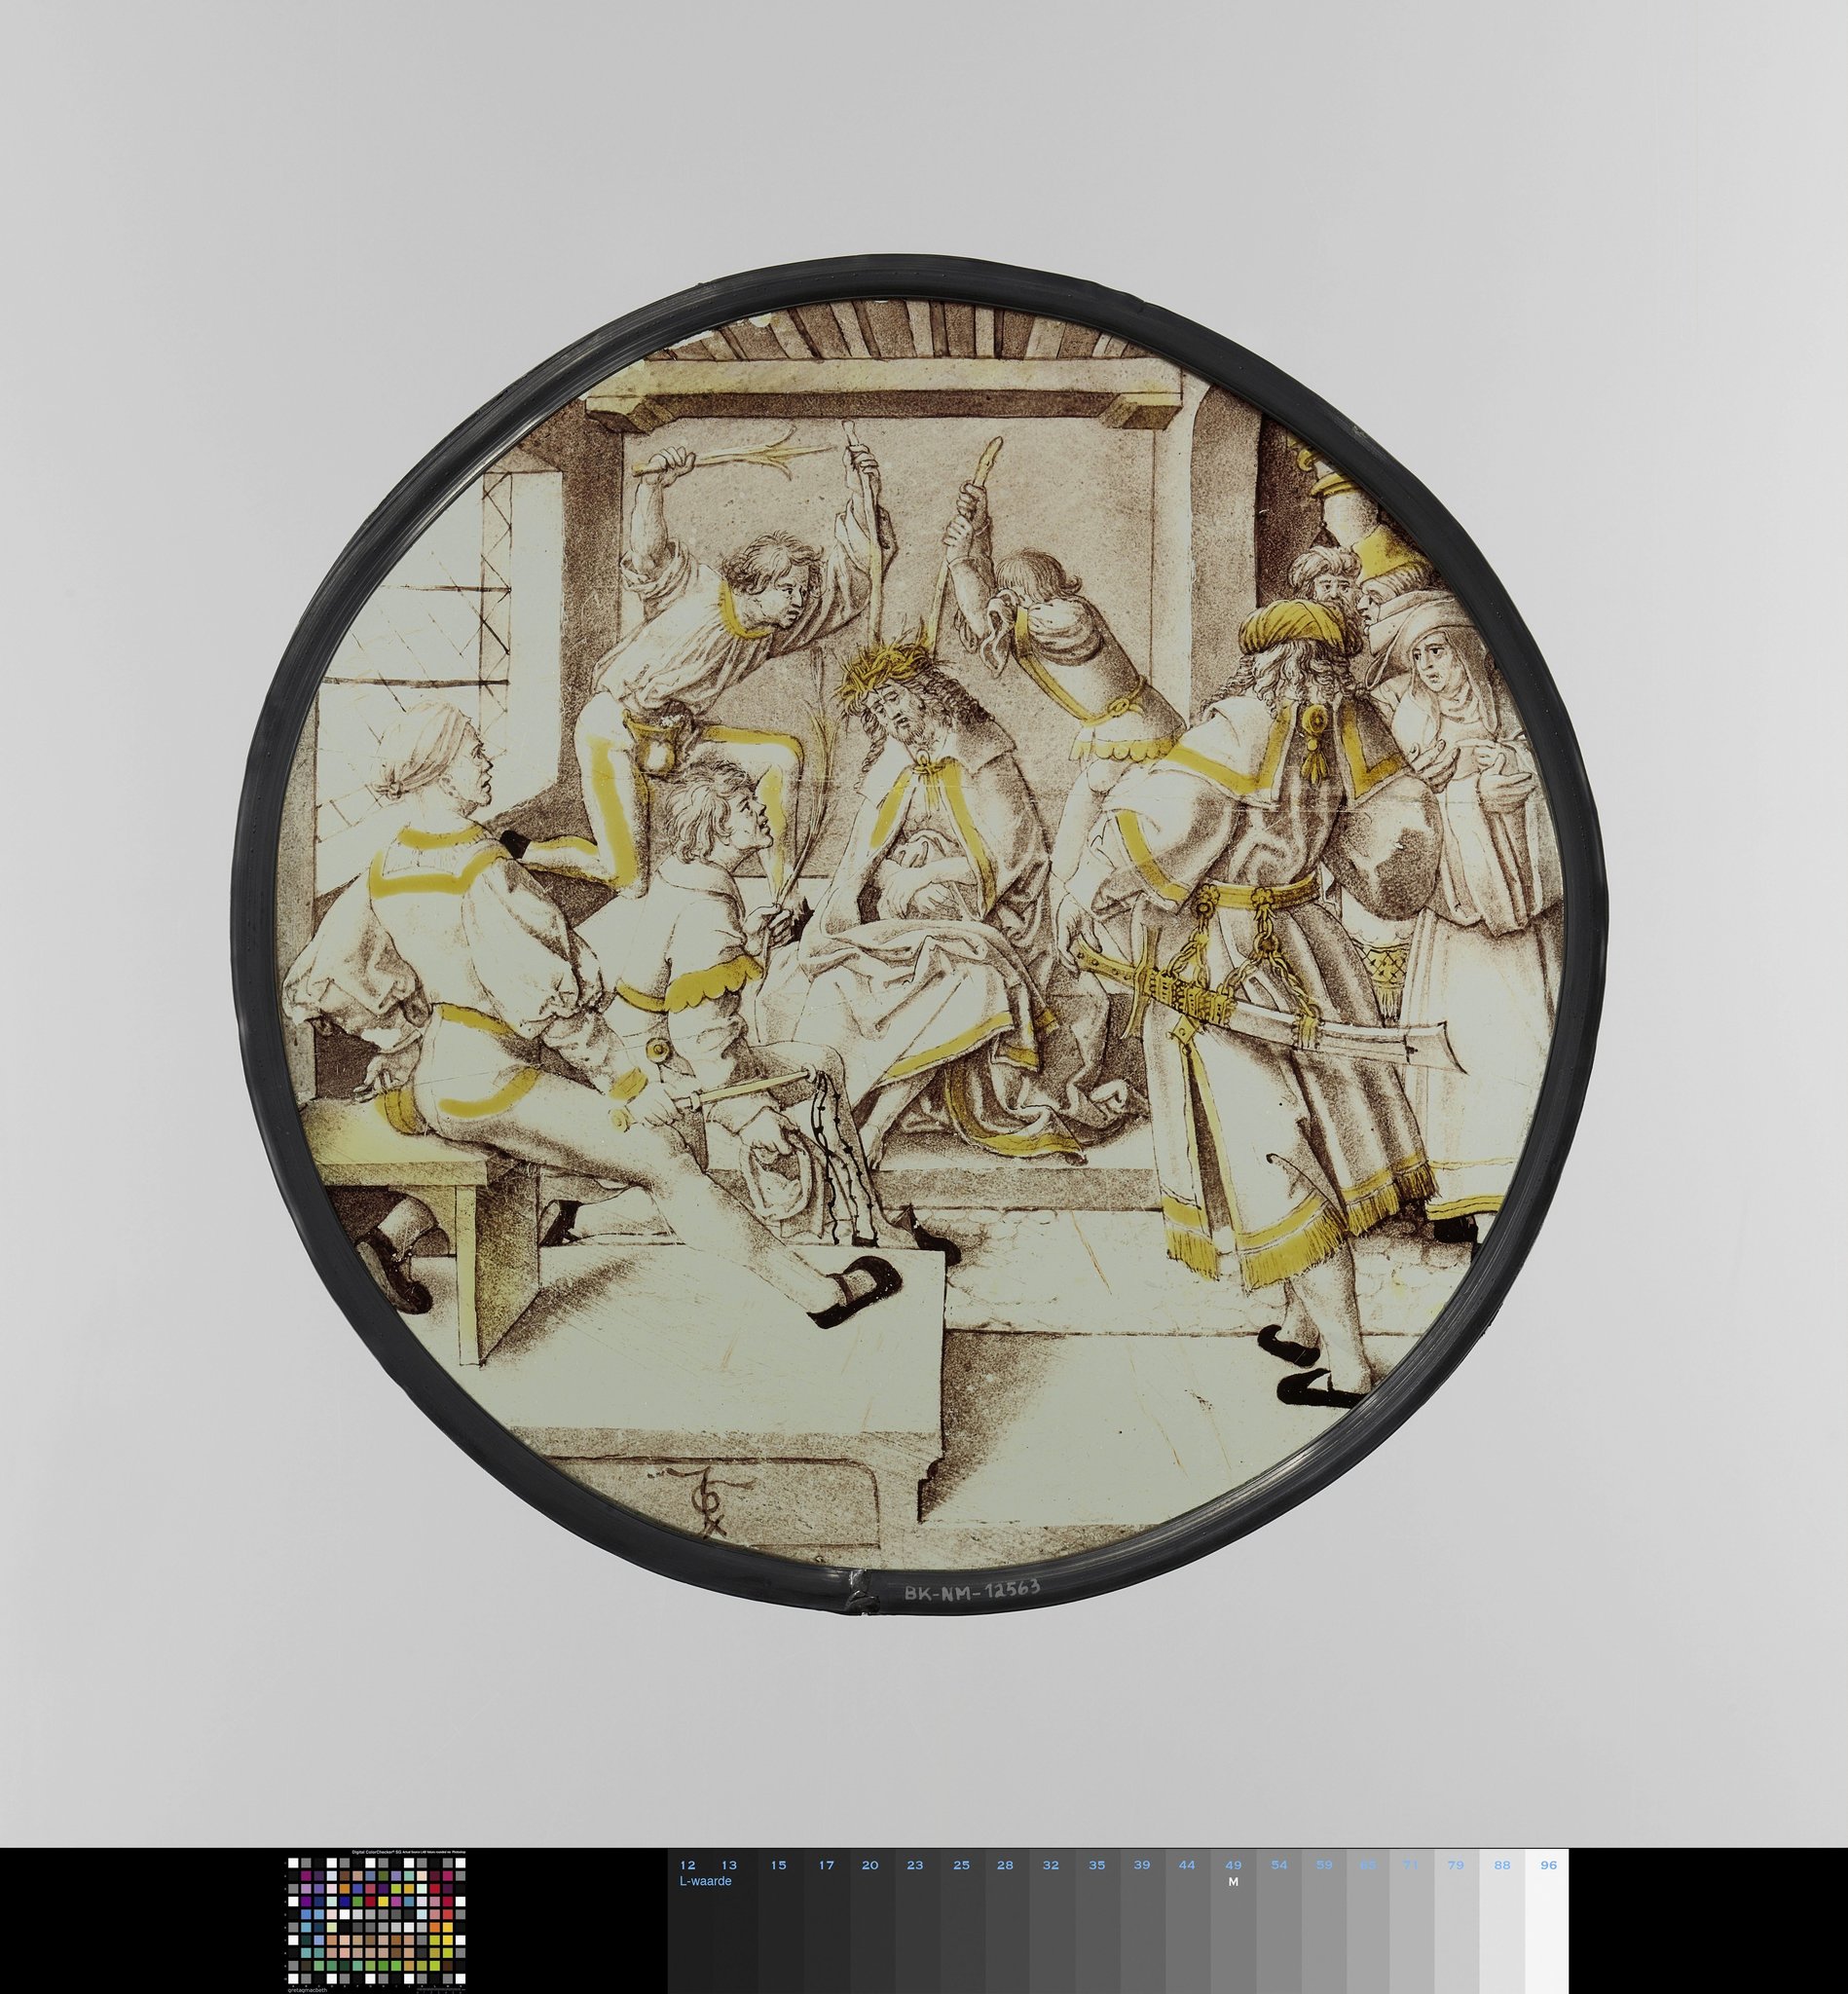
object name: light window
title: De doornenkroning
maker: Anonymous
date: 1515-1520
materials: glass, lead, pigment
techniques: leading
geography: netherlands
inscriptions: house mark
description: The Crowning with Thorns. Stained glass. Netherlands, c. 1510-1525, after Jacob Cornelisz van Oostsanen (c. 1470 - 1533).